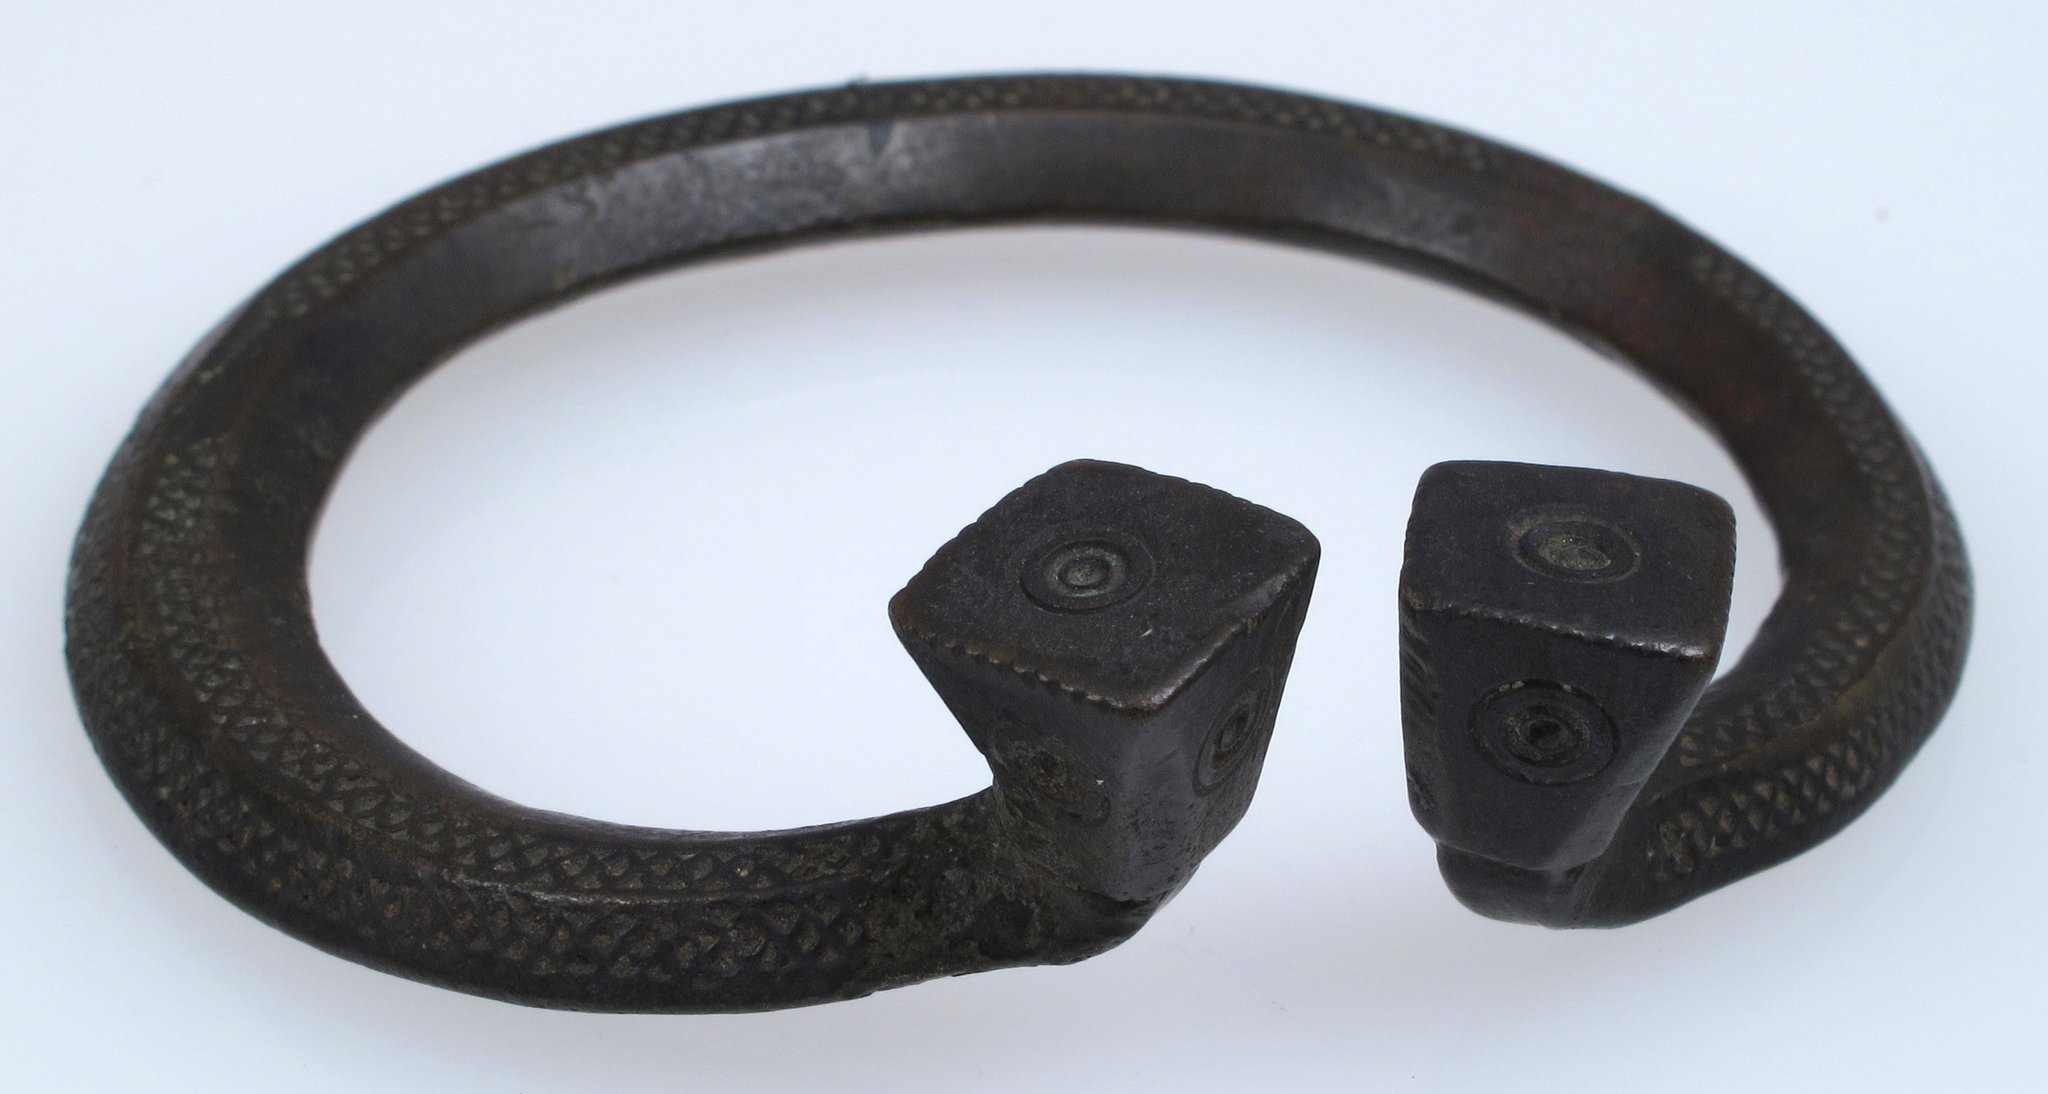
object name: brooch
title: Penannular Brooch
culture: scandinavian or baltic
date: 901-1100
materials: copper alloy